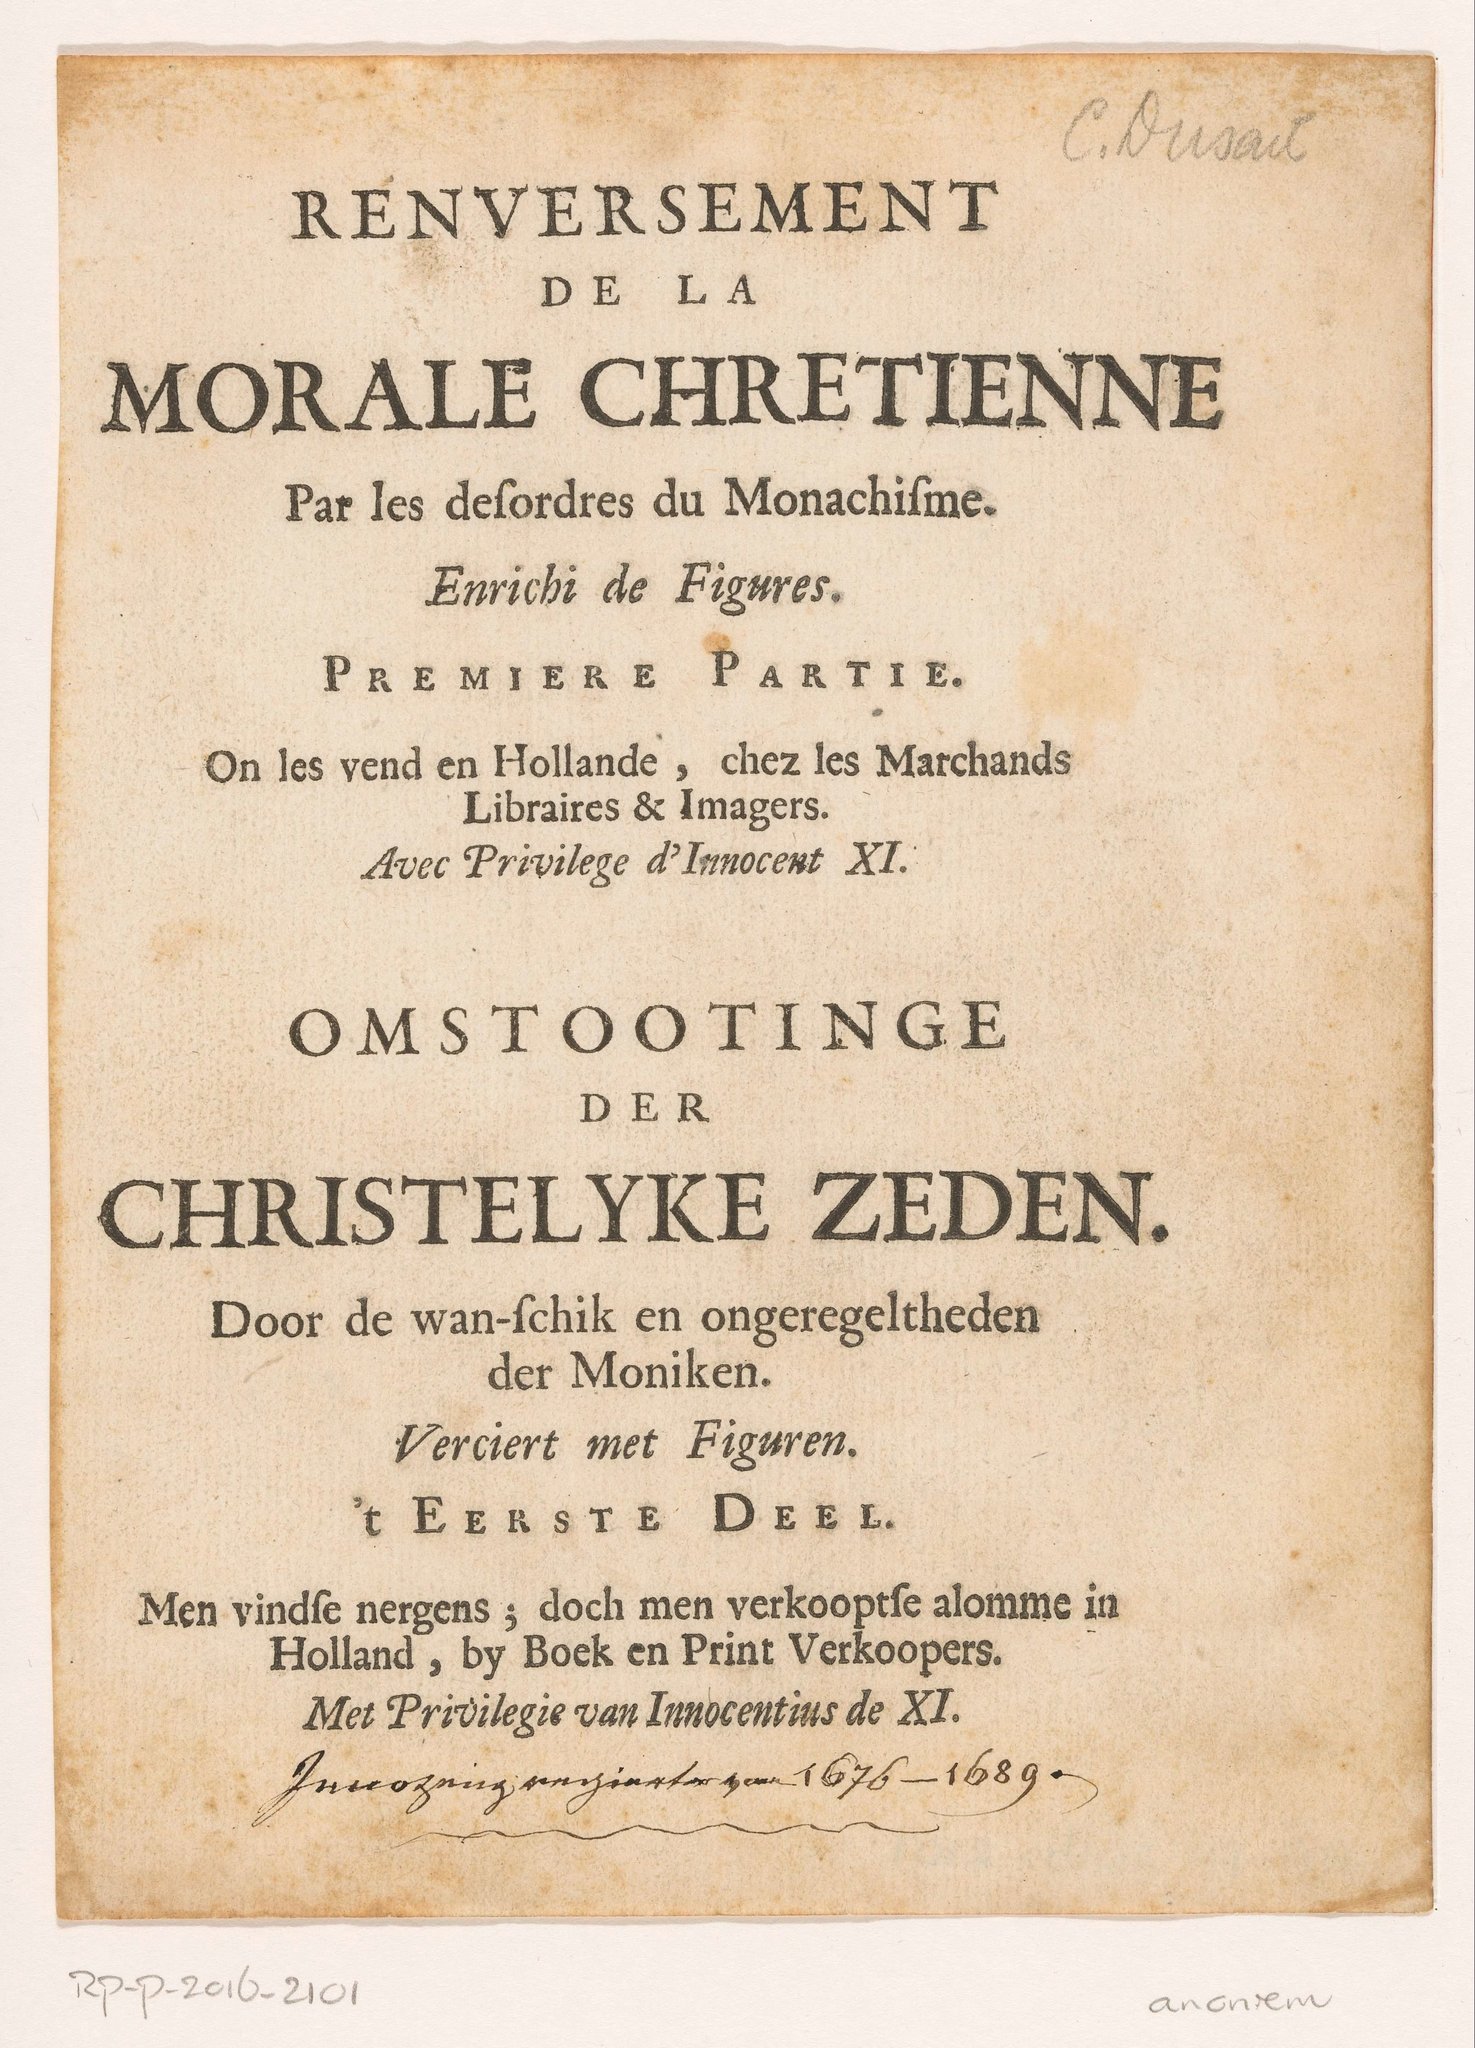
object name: print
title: Titelpagina voor: Cornelis Dusart, Renversement de la morale chretienne (...) Premiere Partie (...) Omstooting der christelyke zeden (...) 't Eerste Deel, s.a.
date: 1676-1689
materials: paper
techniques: letterpress printing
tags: title-page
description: Titelpagina voor: Dusart, Cornelis. Renversement de la morale chretienne (...) Premiere Partie (...) Omstooting der christelyke zeden (...) 't Eerste Deel. S.l.: S.n., s.a.